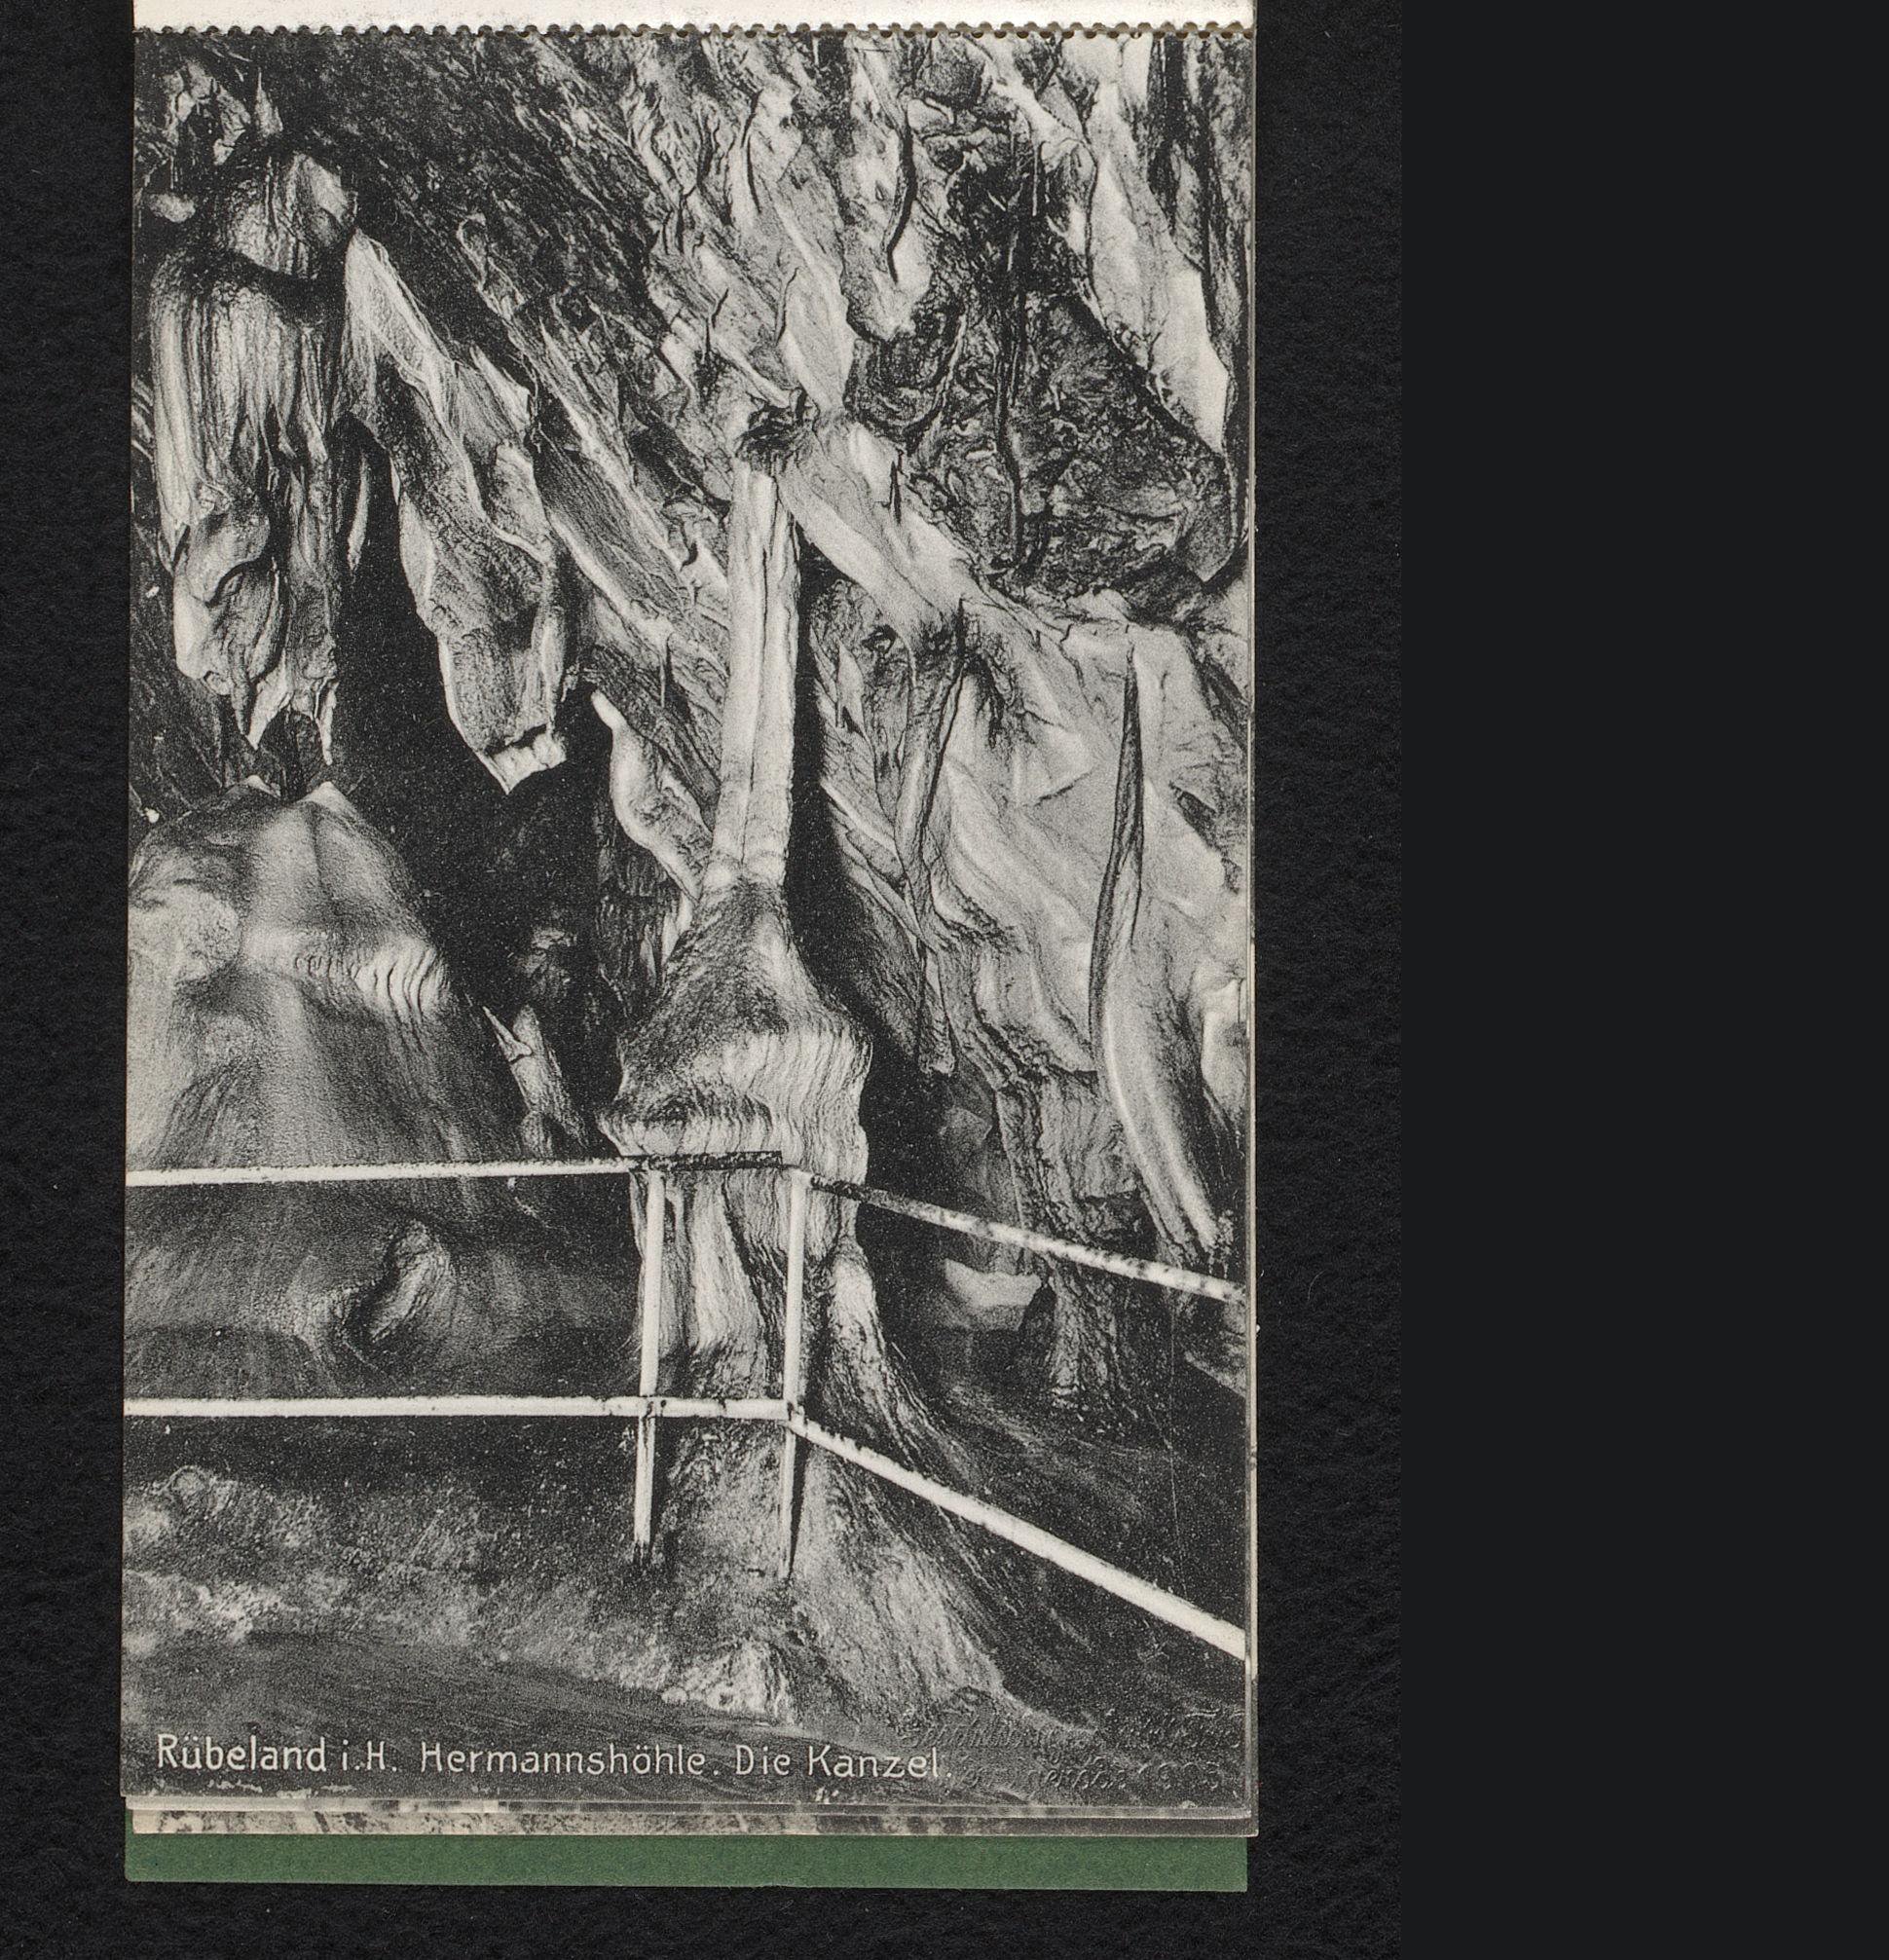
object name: ansichtkaart, prentbriefkaart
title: Rübeland i. H. Hermannshöhle. Die Kanzel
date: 1907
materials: cardboard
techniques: photograph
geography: rübeland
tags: stalactitic cave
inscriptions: date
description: Prentbriefkaart maakt deel uit van een album.